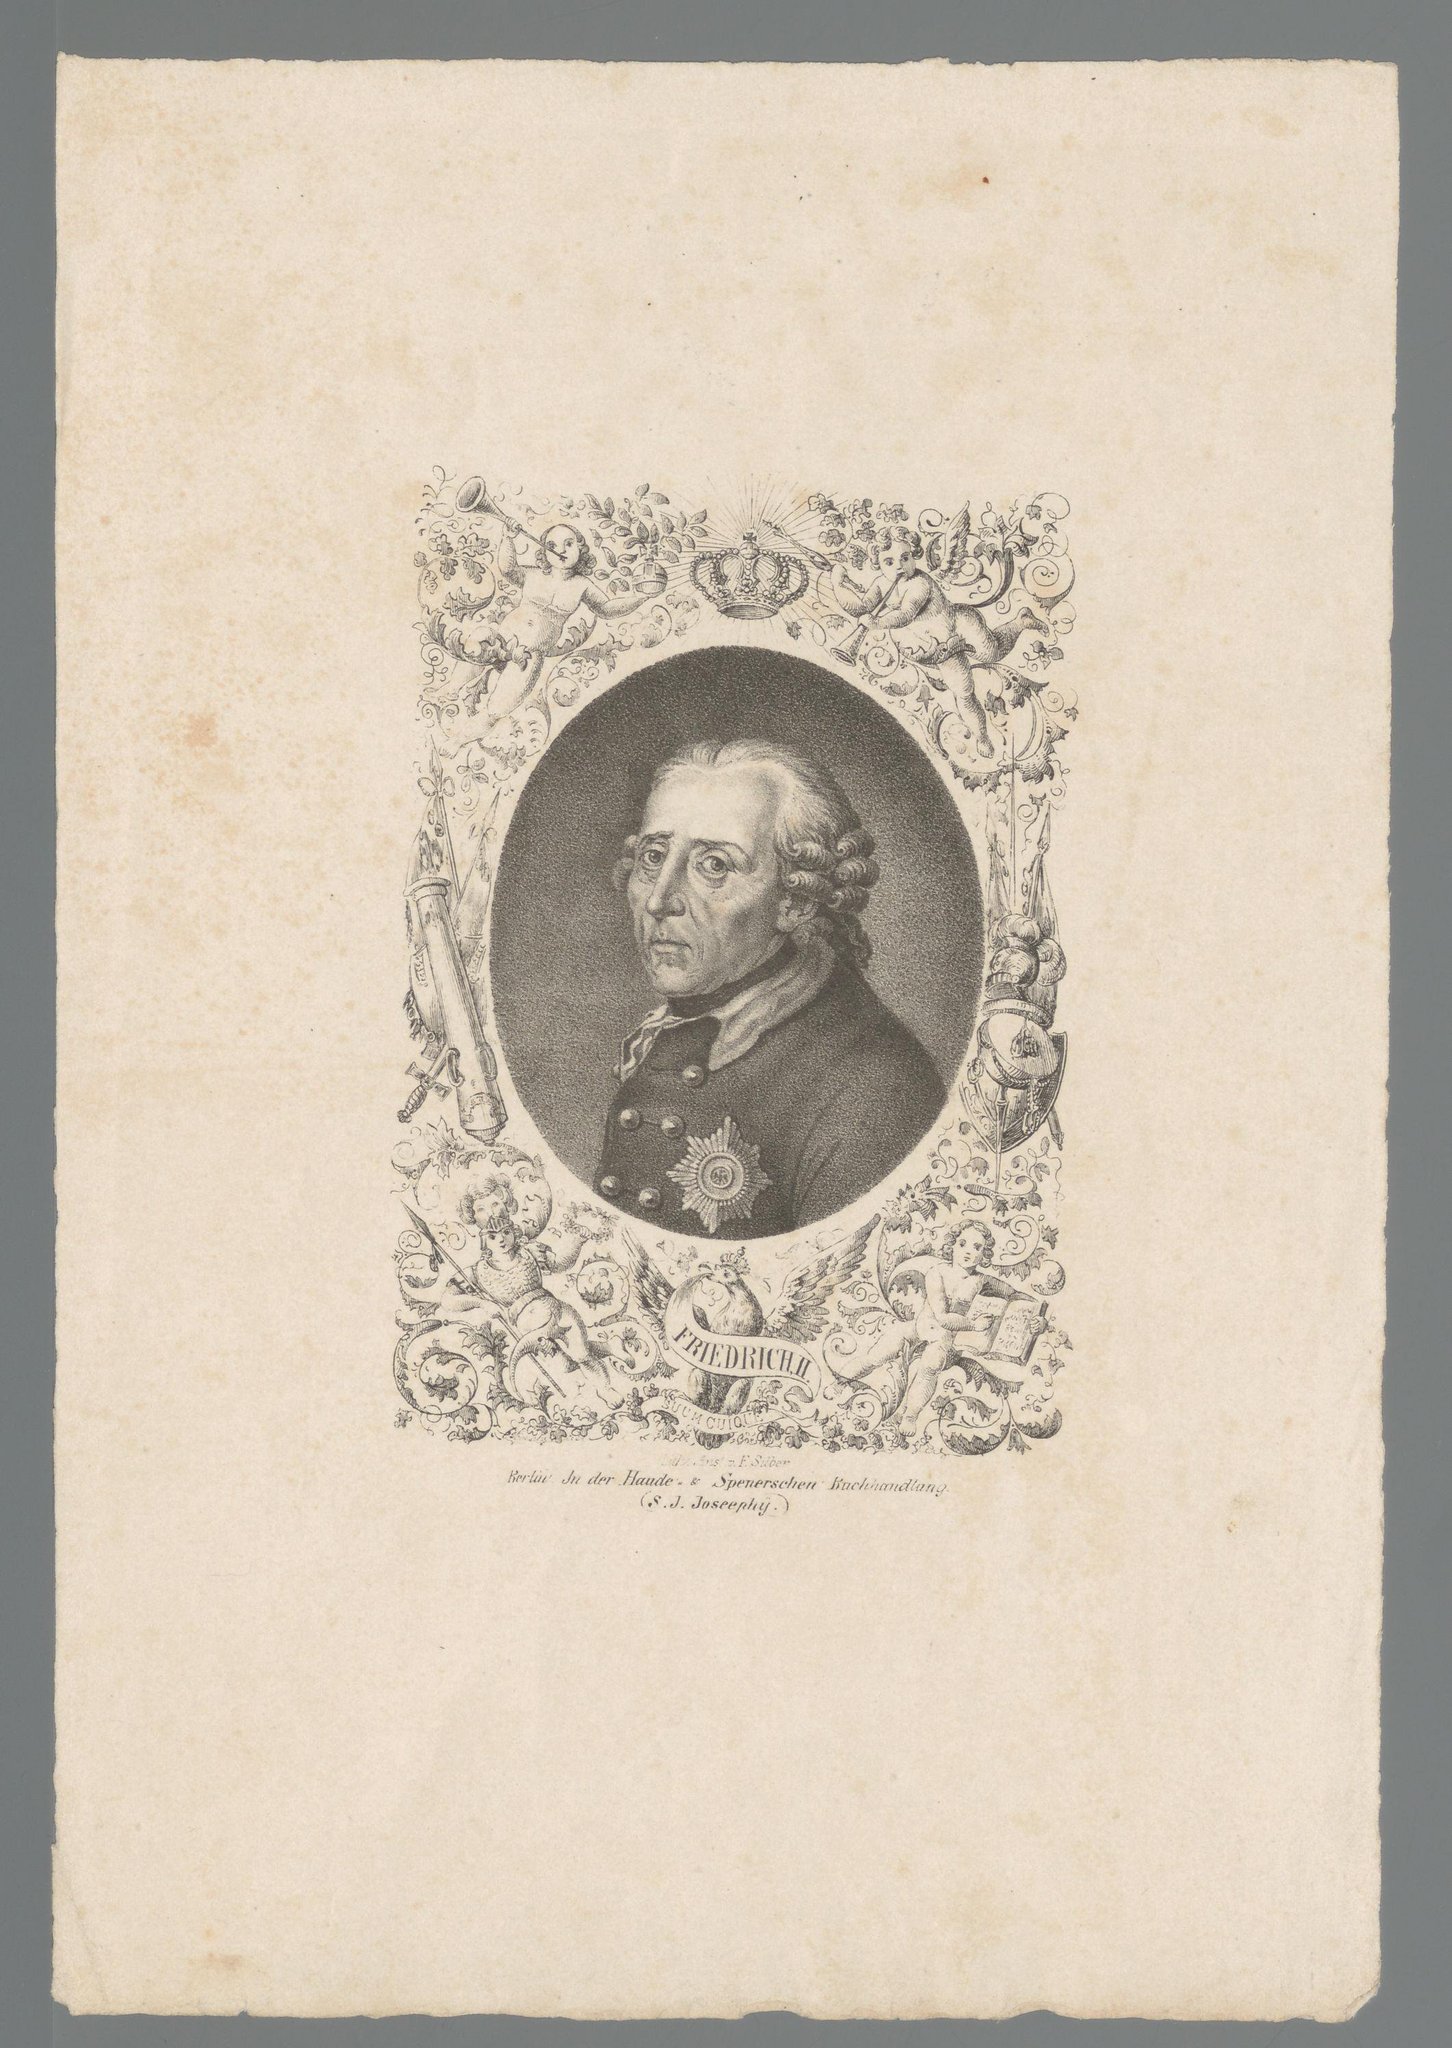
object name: print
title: Friedrich II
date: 1810-1826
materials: paper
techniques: lithograph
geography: berlin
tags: berlin, frederick ii (king of prussia), ornaments ~ art, adult man, historical persons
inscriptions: collector's mark: Lugt 2228